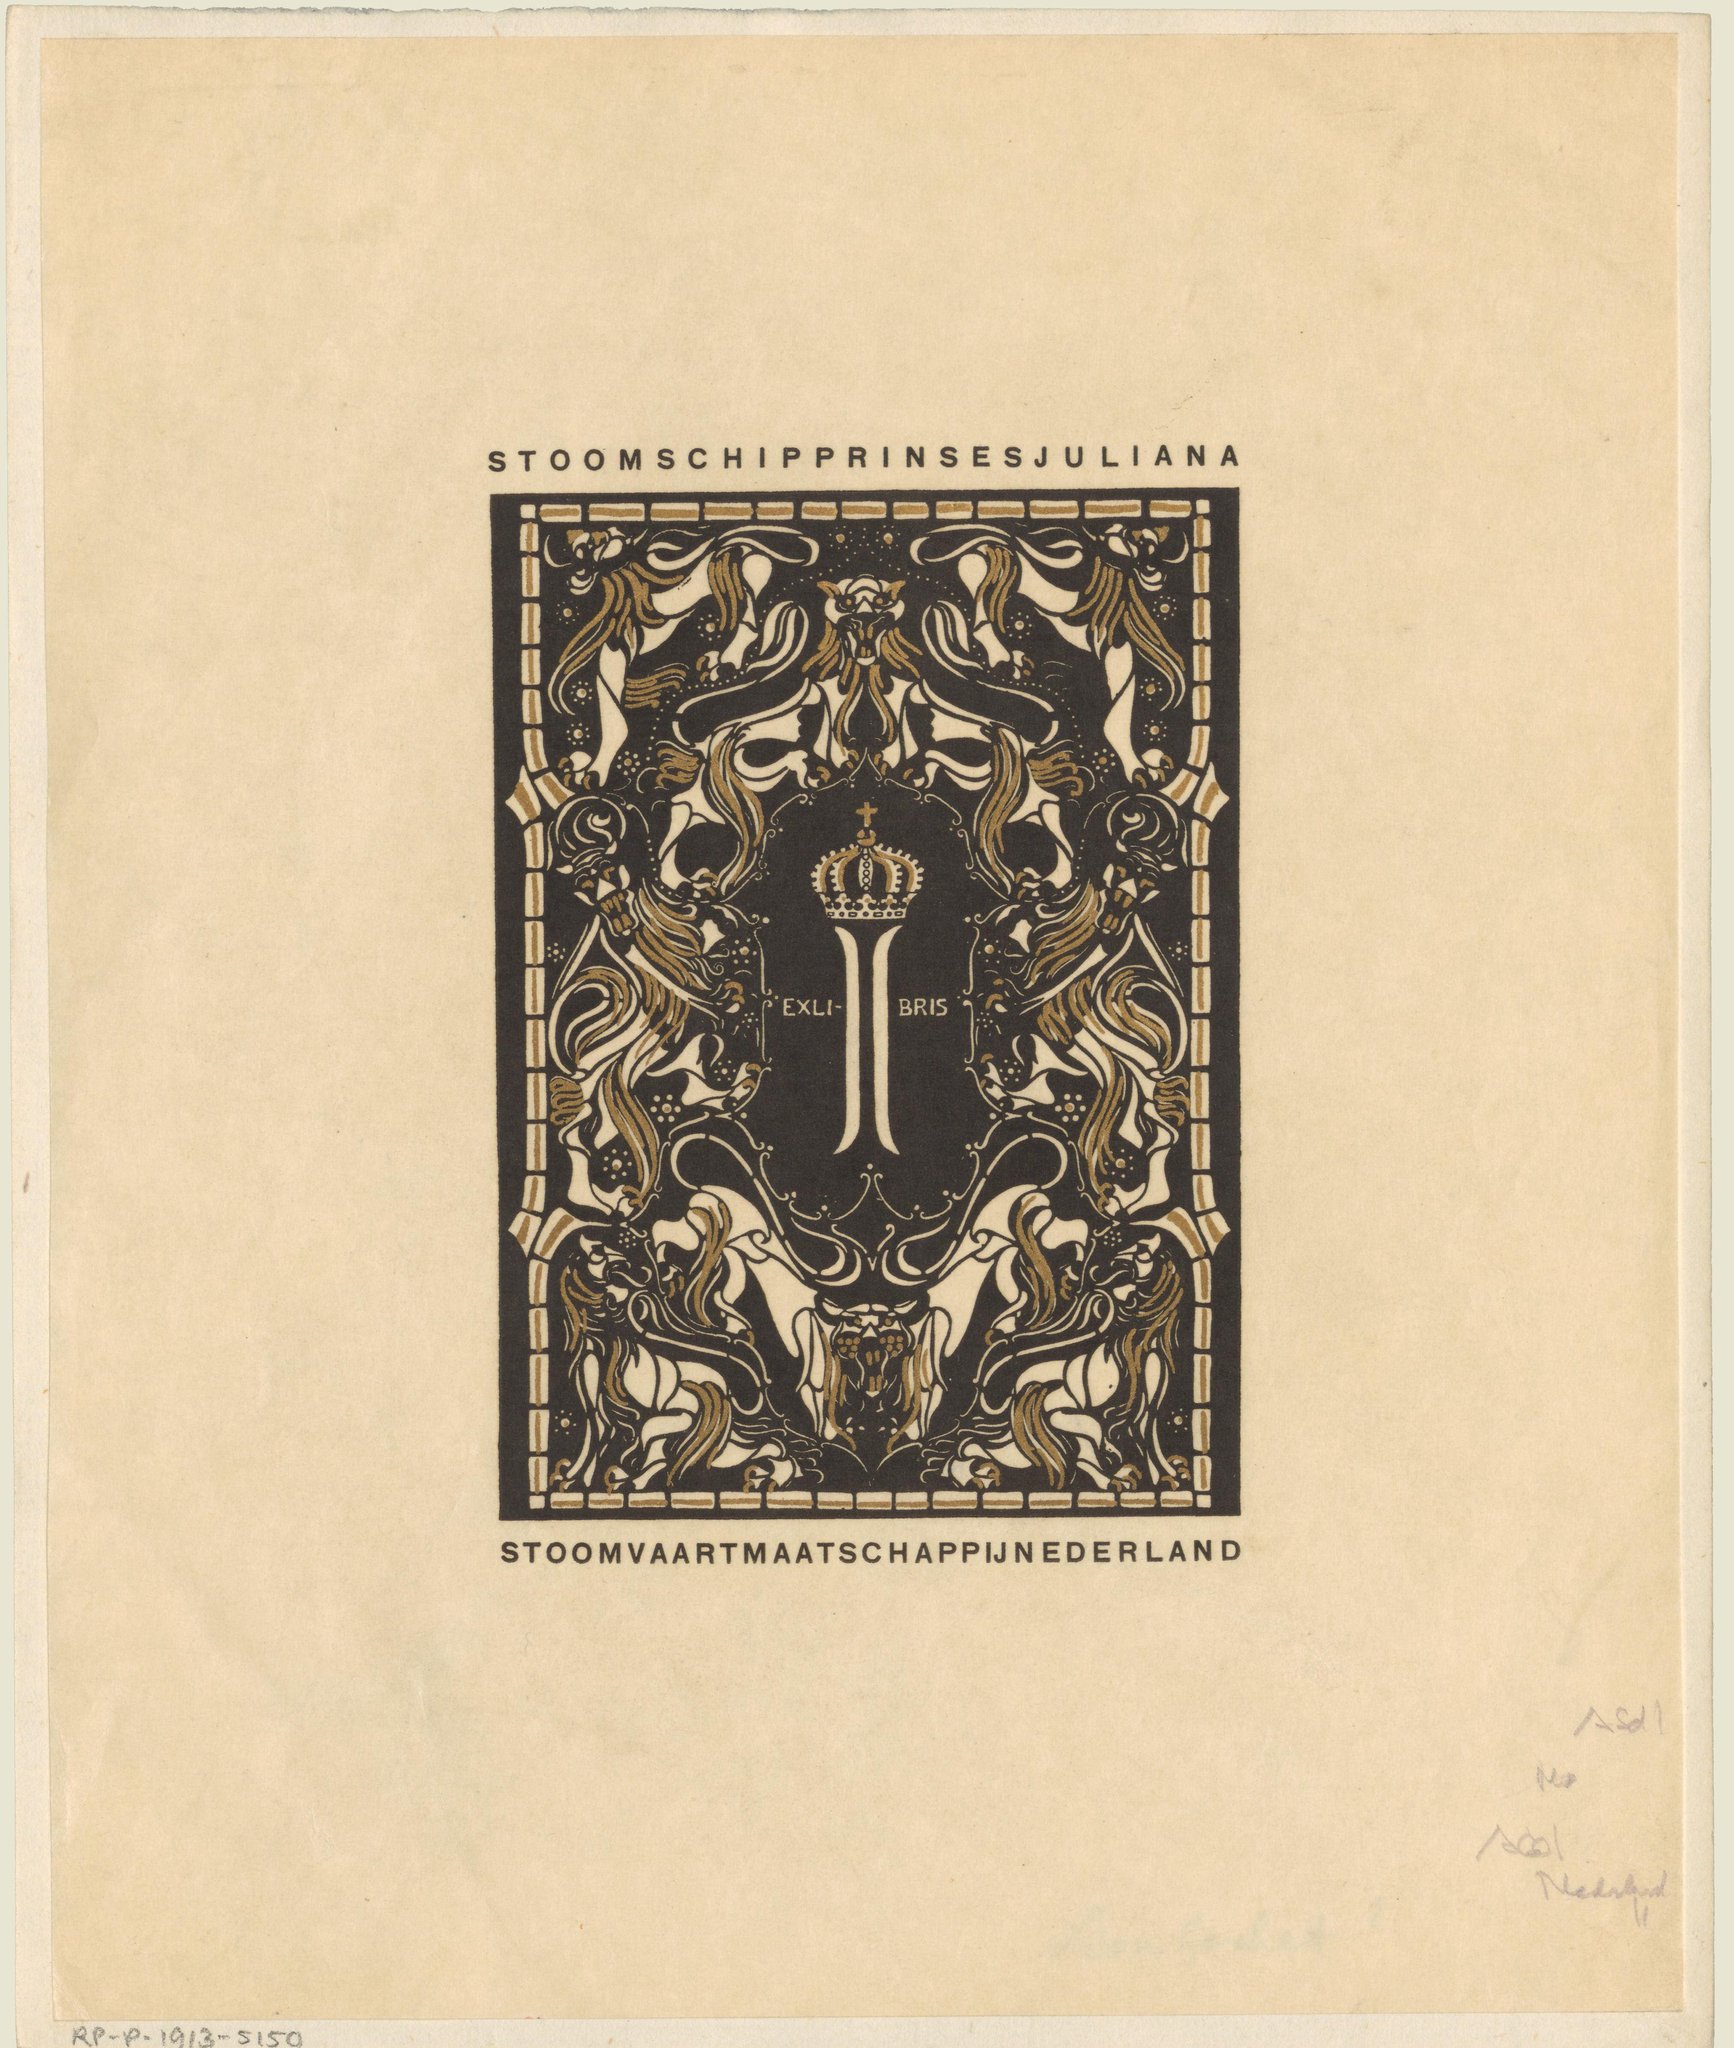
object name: bookplate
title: Ex libris van het stoomschip Prinses Juliana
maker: carel adolph lion cachet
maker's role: draughtsman, print maker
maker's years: 1864-1945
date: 1910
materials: paper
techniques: printing block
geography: netherlands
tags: crown (symbol of sovereignty), beasts of prey, predatory animals: lion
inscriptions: collector's mark: Lugt 2233